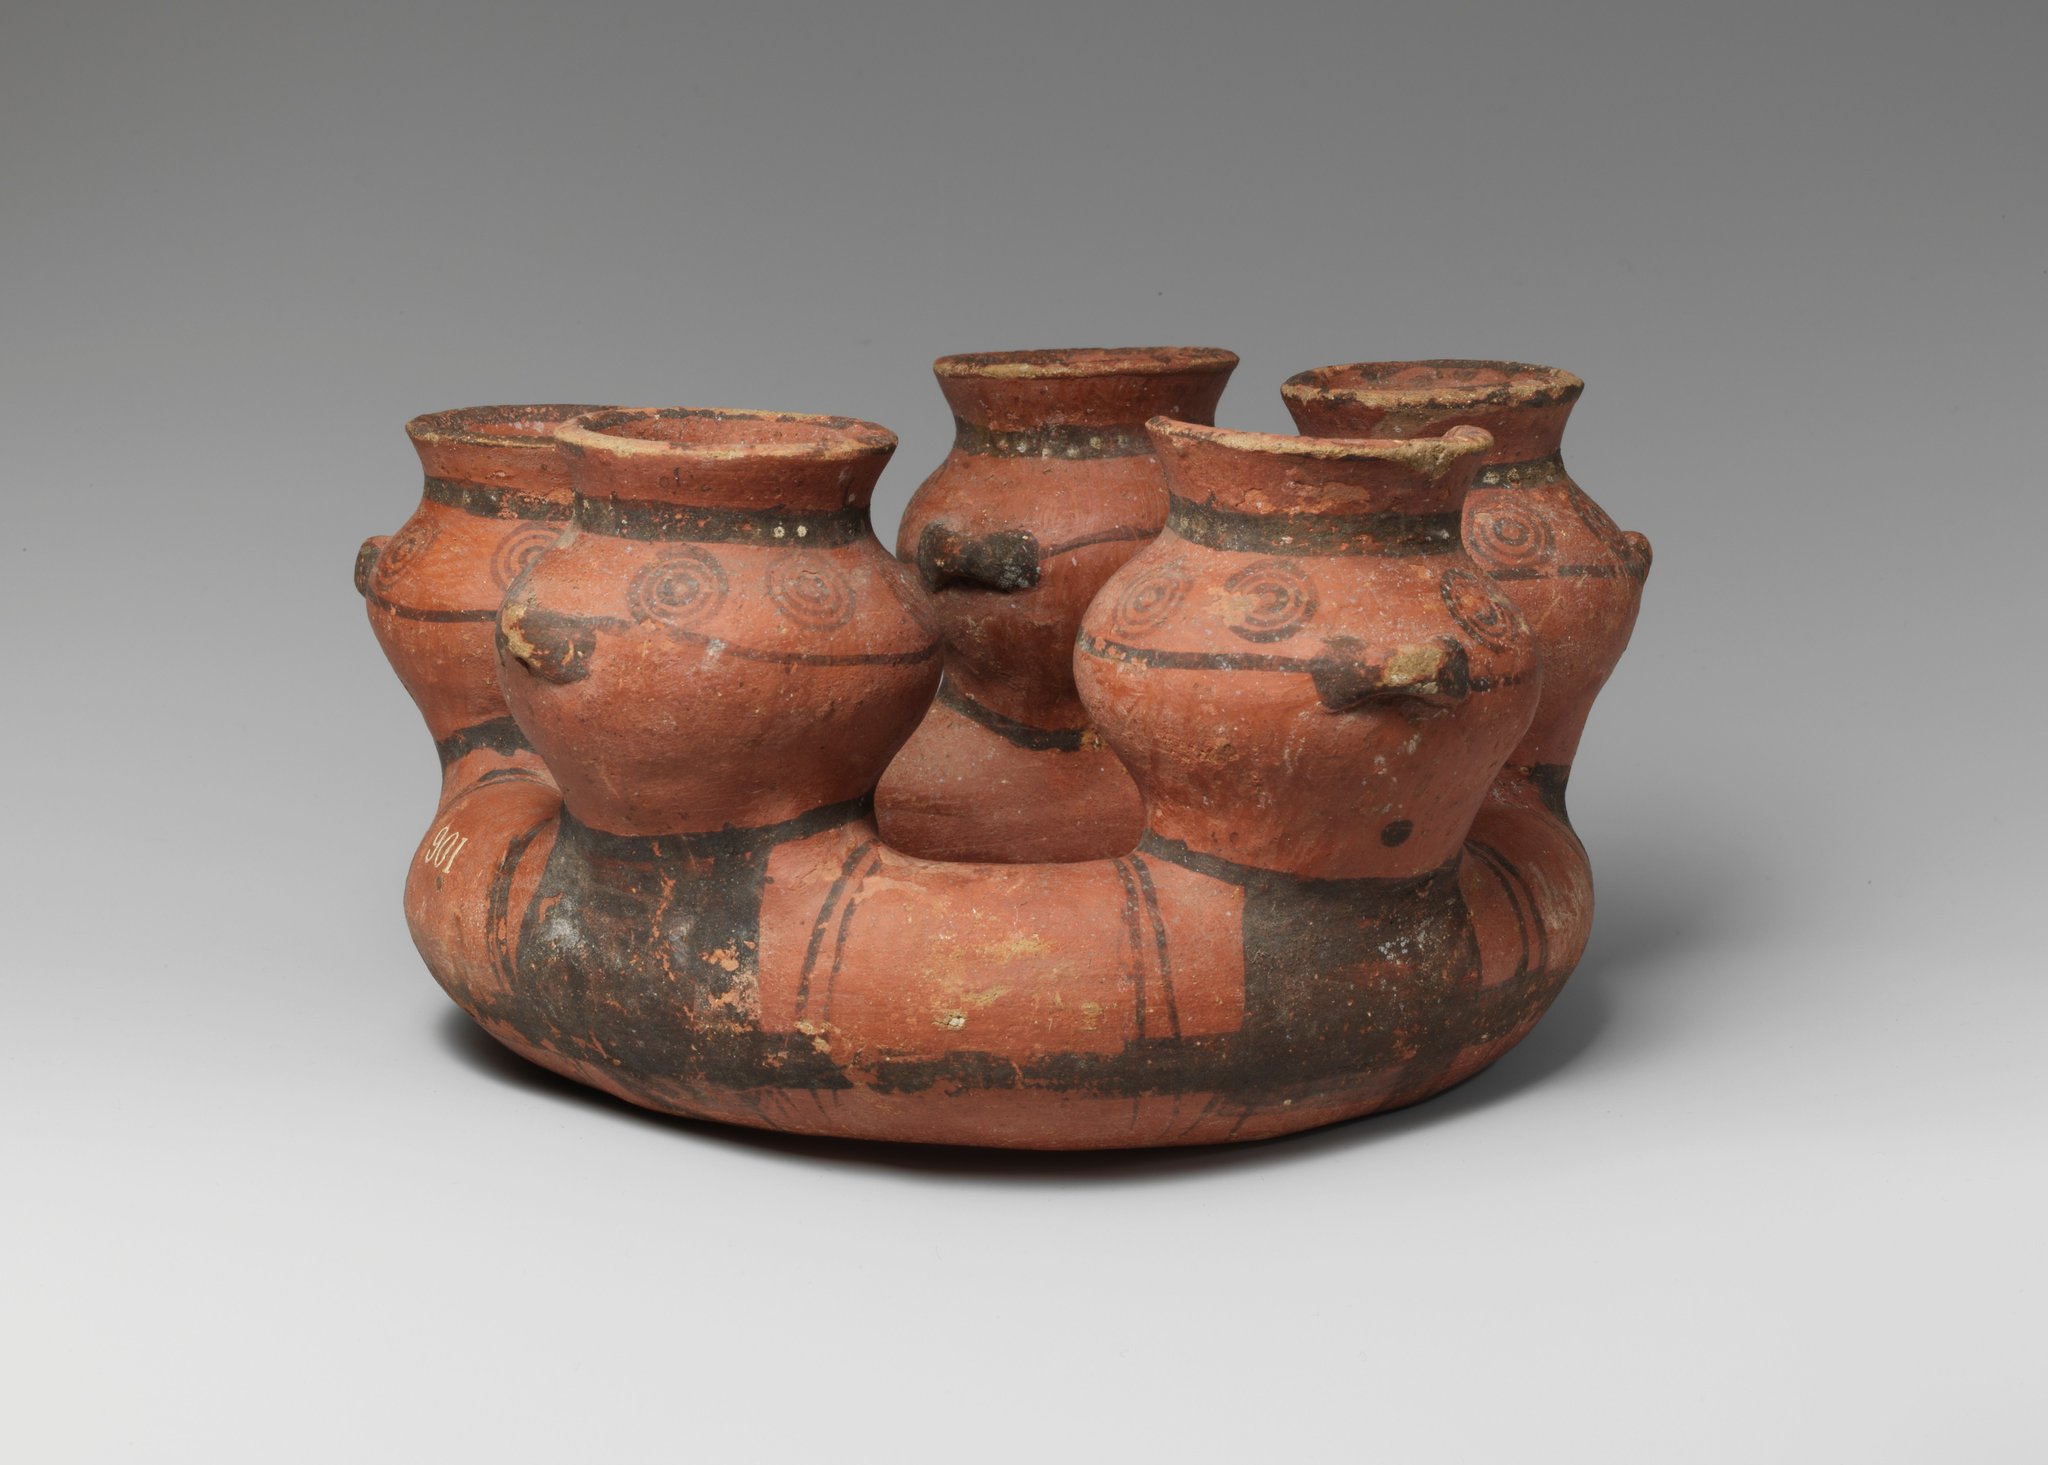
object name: kernos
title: Terracotta kernos (vase for multiple offerings)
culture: cypriot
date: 750-600 BCE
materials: terracotta